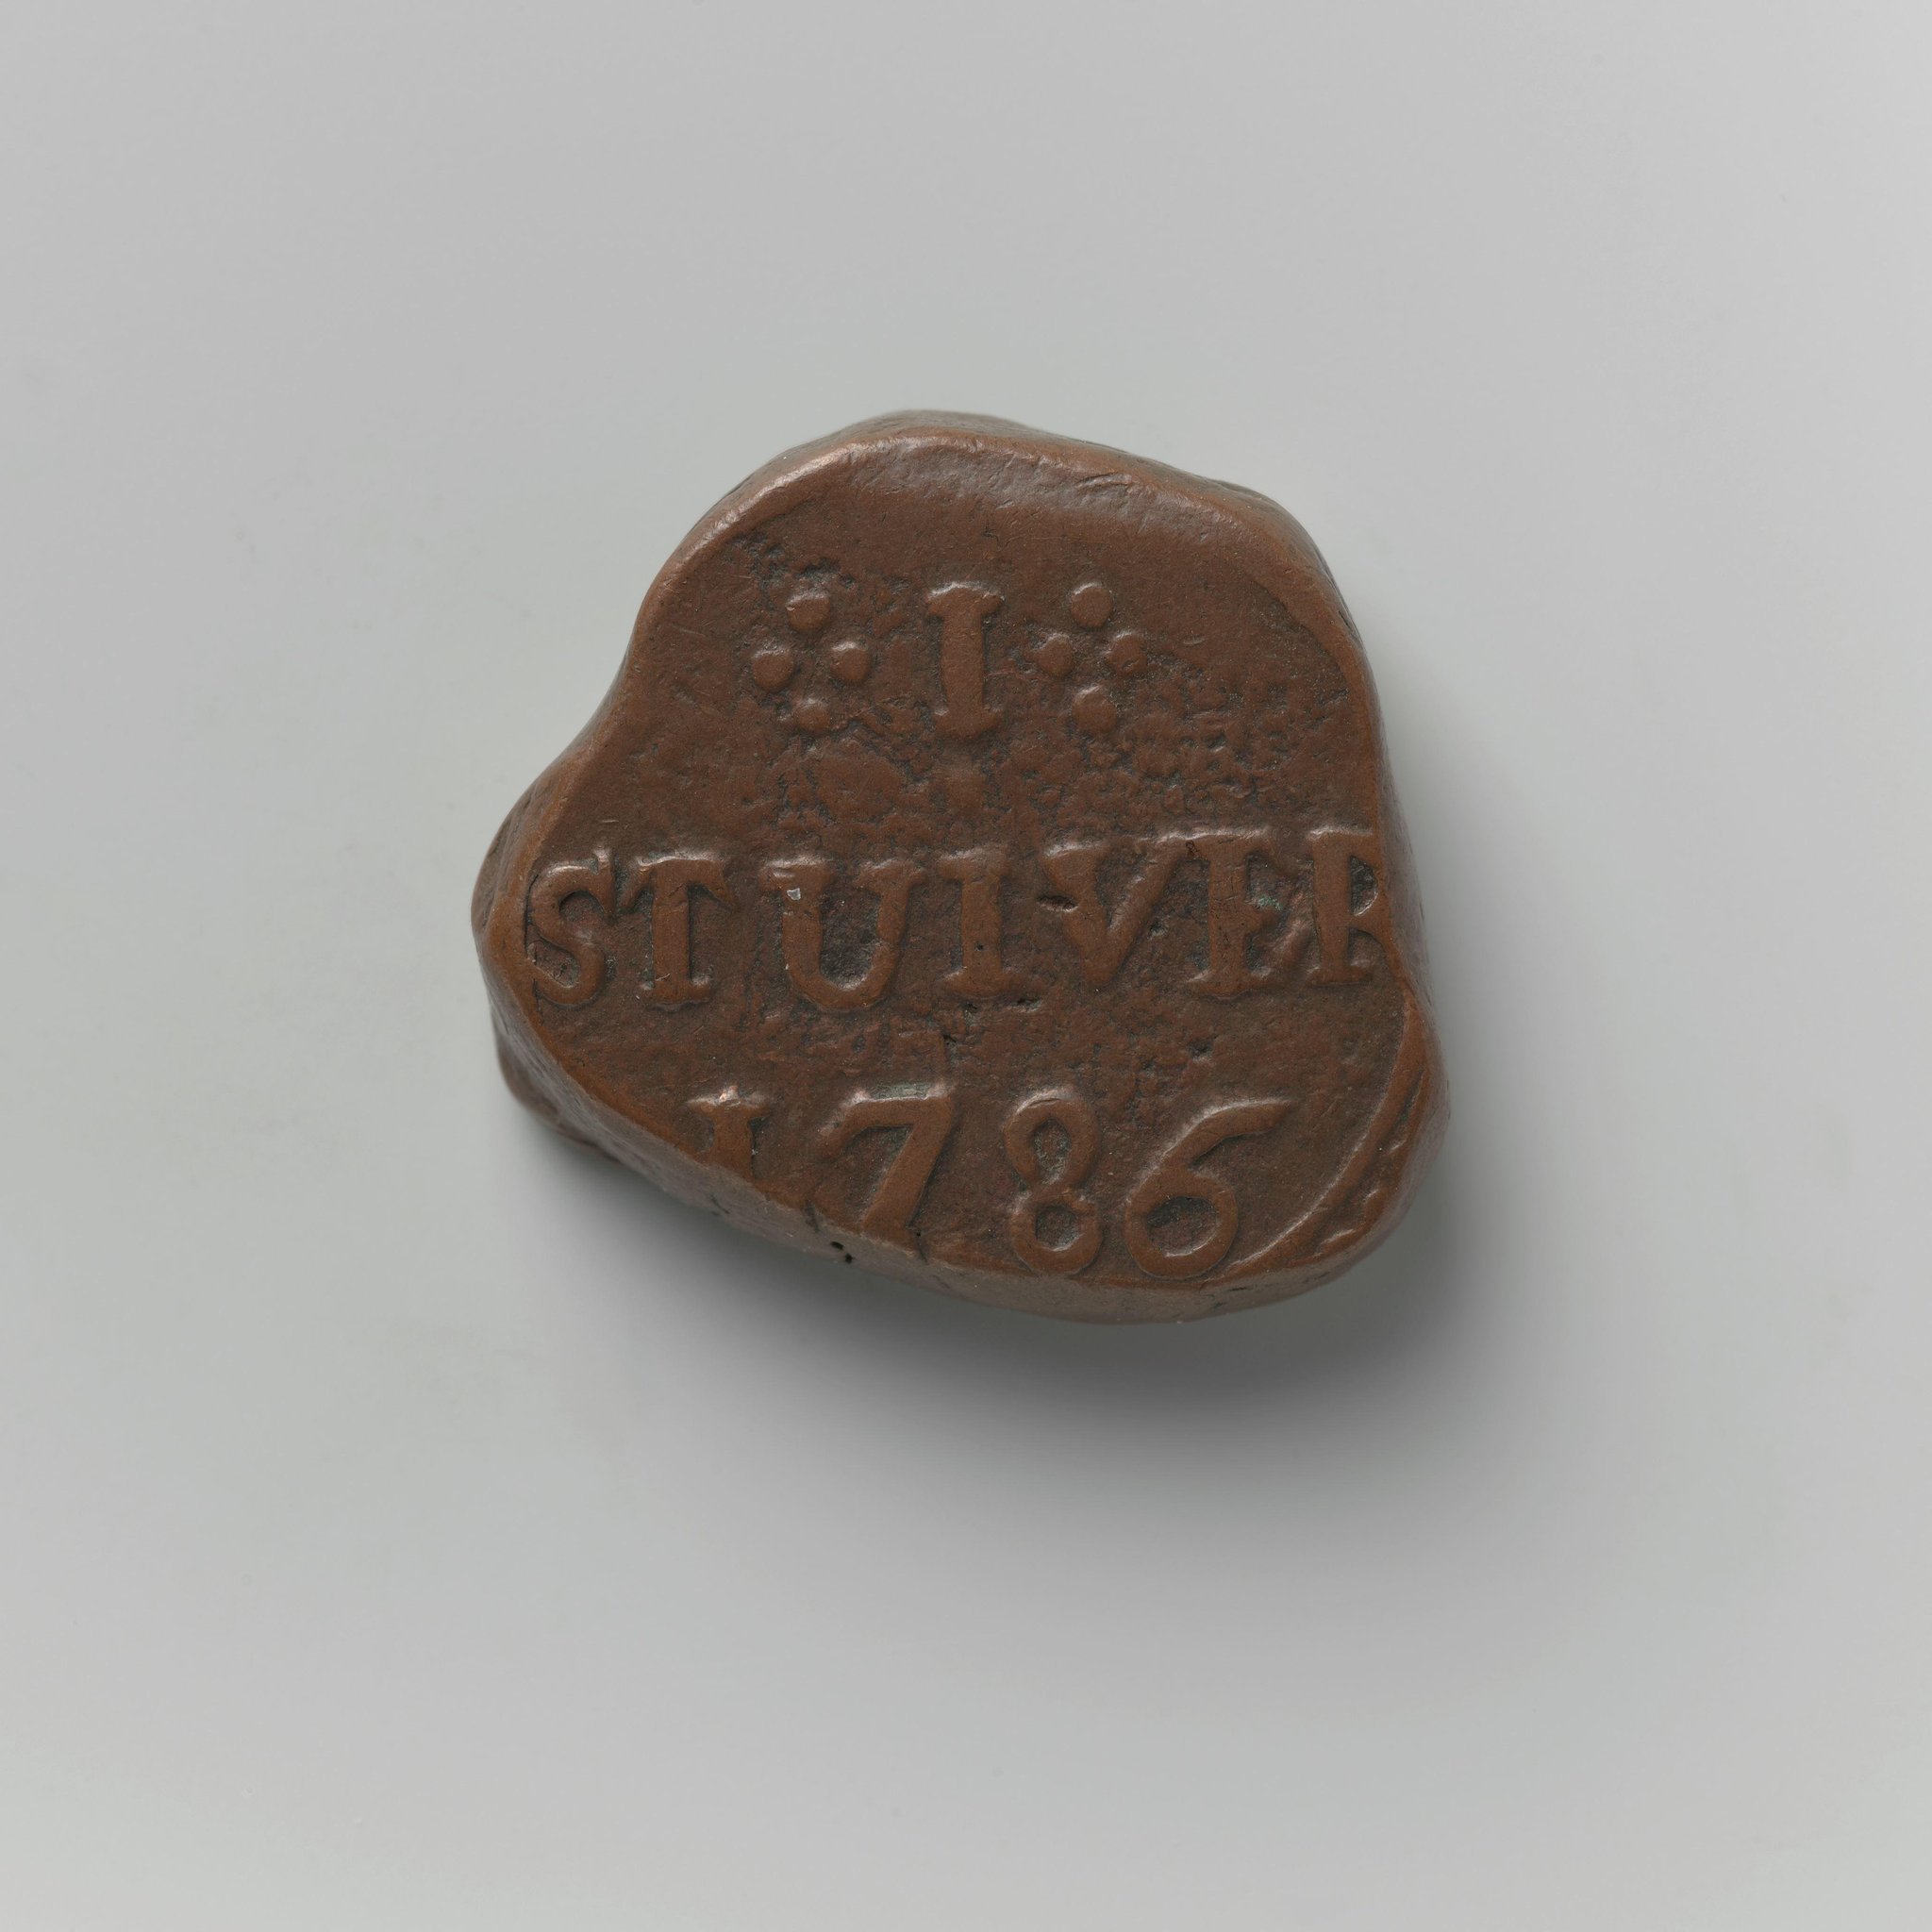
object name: coin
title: Stuiver van Ceylon, 1786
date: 1786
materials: copper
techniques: striking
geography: colombo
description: Koperen munt. Voorzijde: monogram van de VOC, waarboven letter C. Keerzijde:eenregelig opschrift: waarde-aanduiding stuiver, waarboven I en waaronder jaartal. Gladde rand.